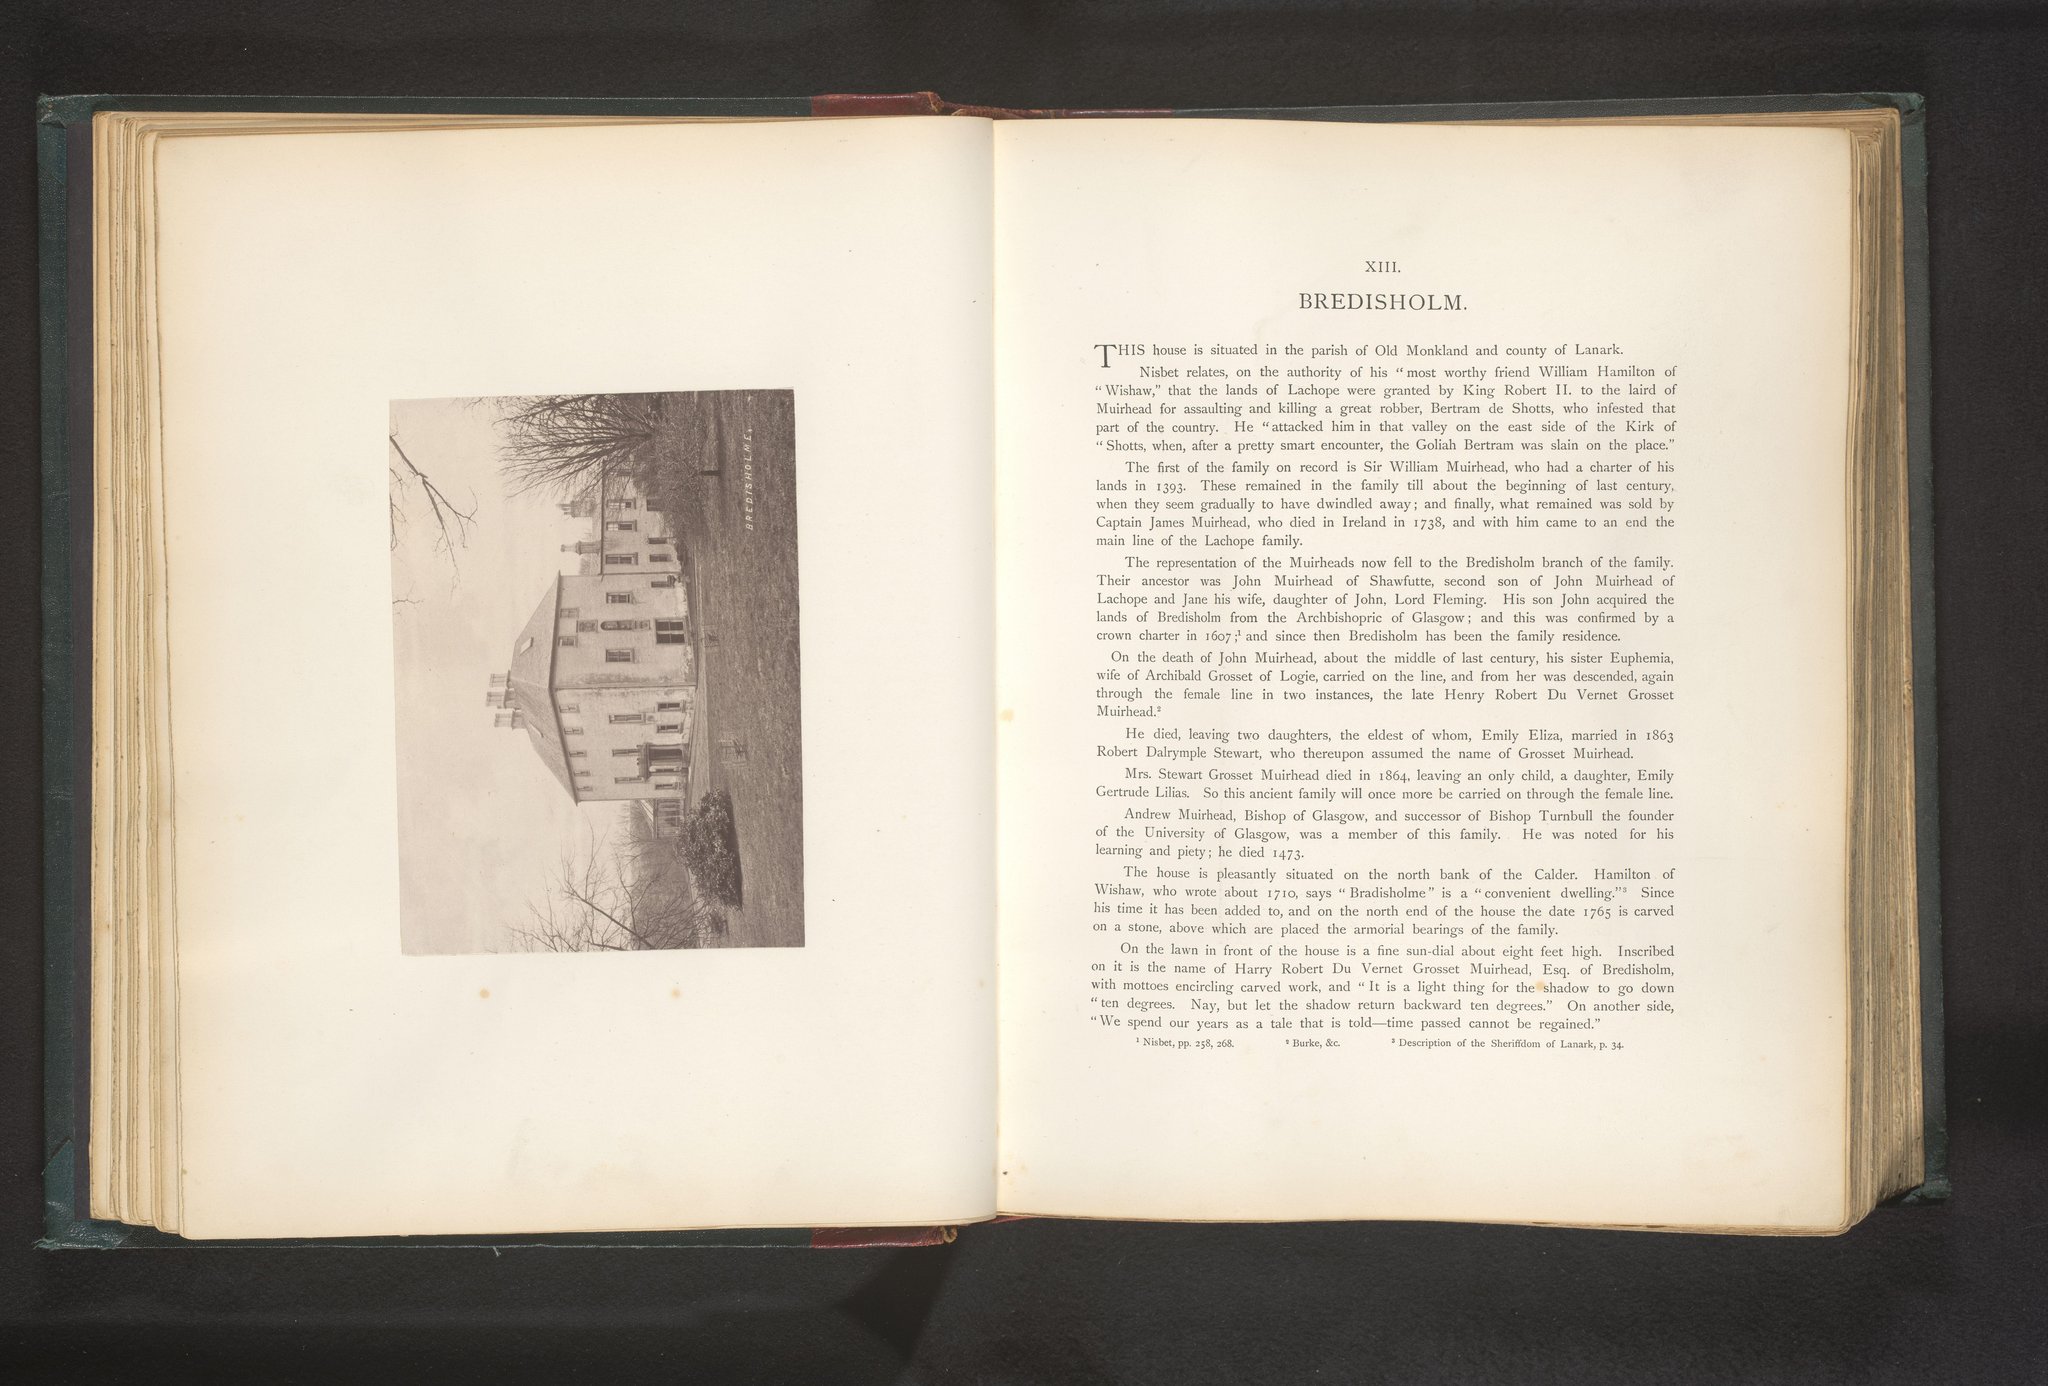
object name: page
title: Bredisholme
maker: thomas annan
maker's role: fotograaf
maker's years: 1829-1887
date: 1868-1878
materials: paper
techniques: carbon print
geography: glasgow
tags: rural housing, e.g. country-house, villa, cottage, façade (of house or building)